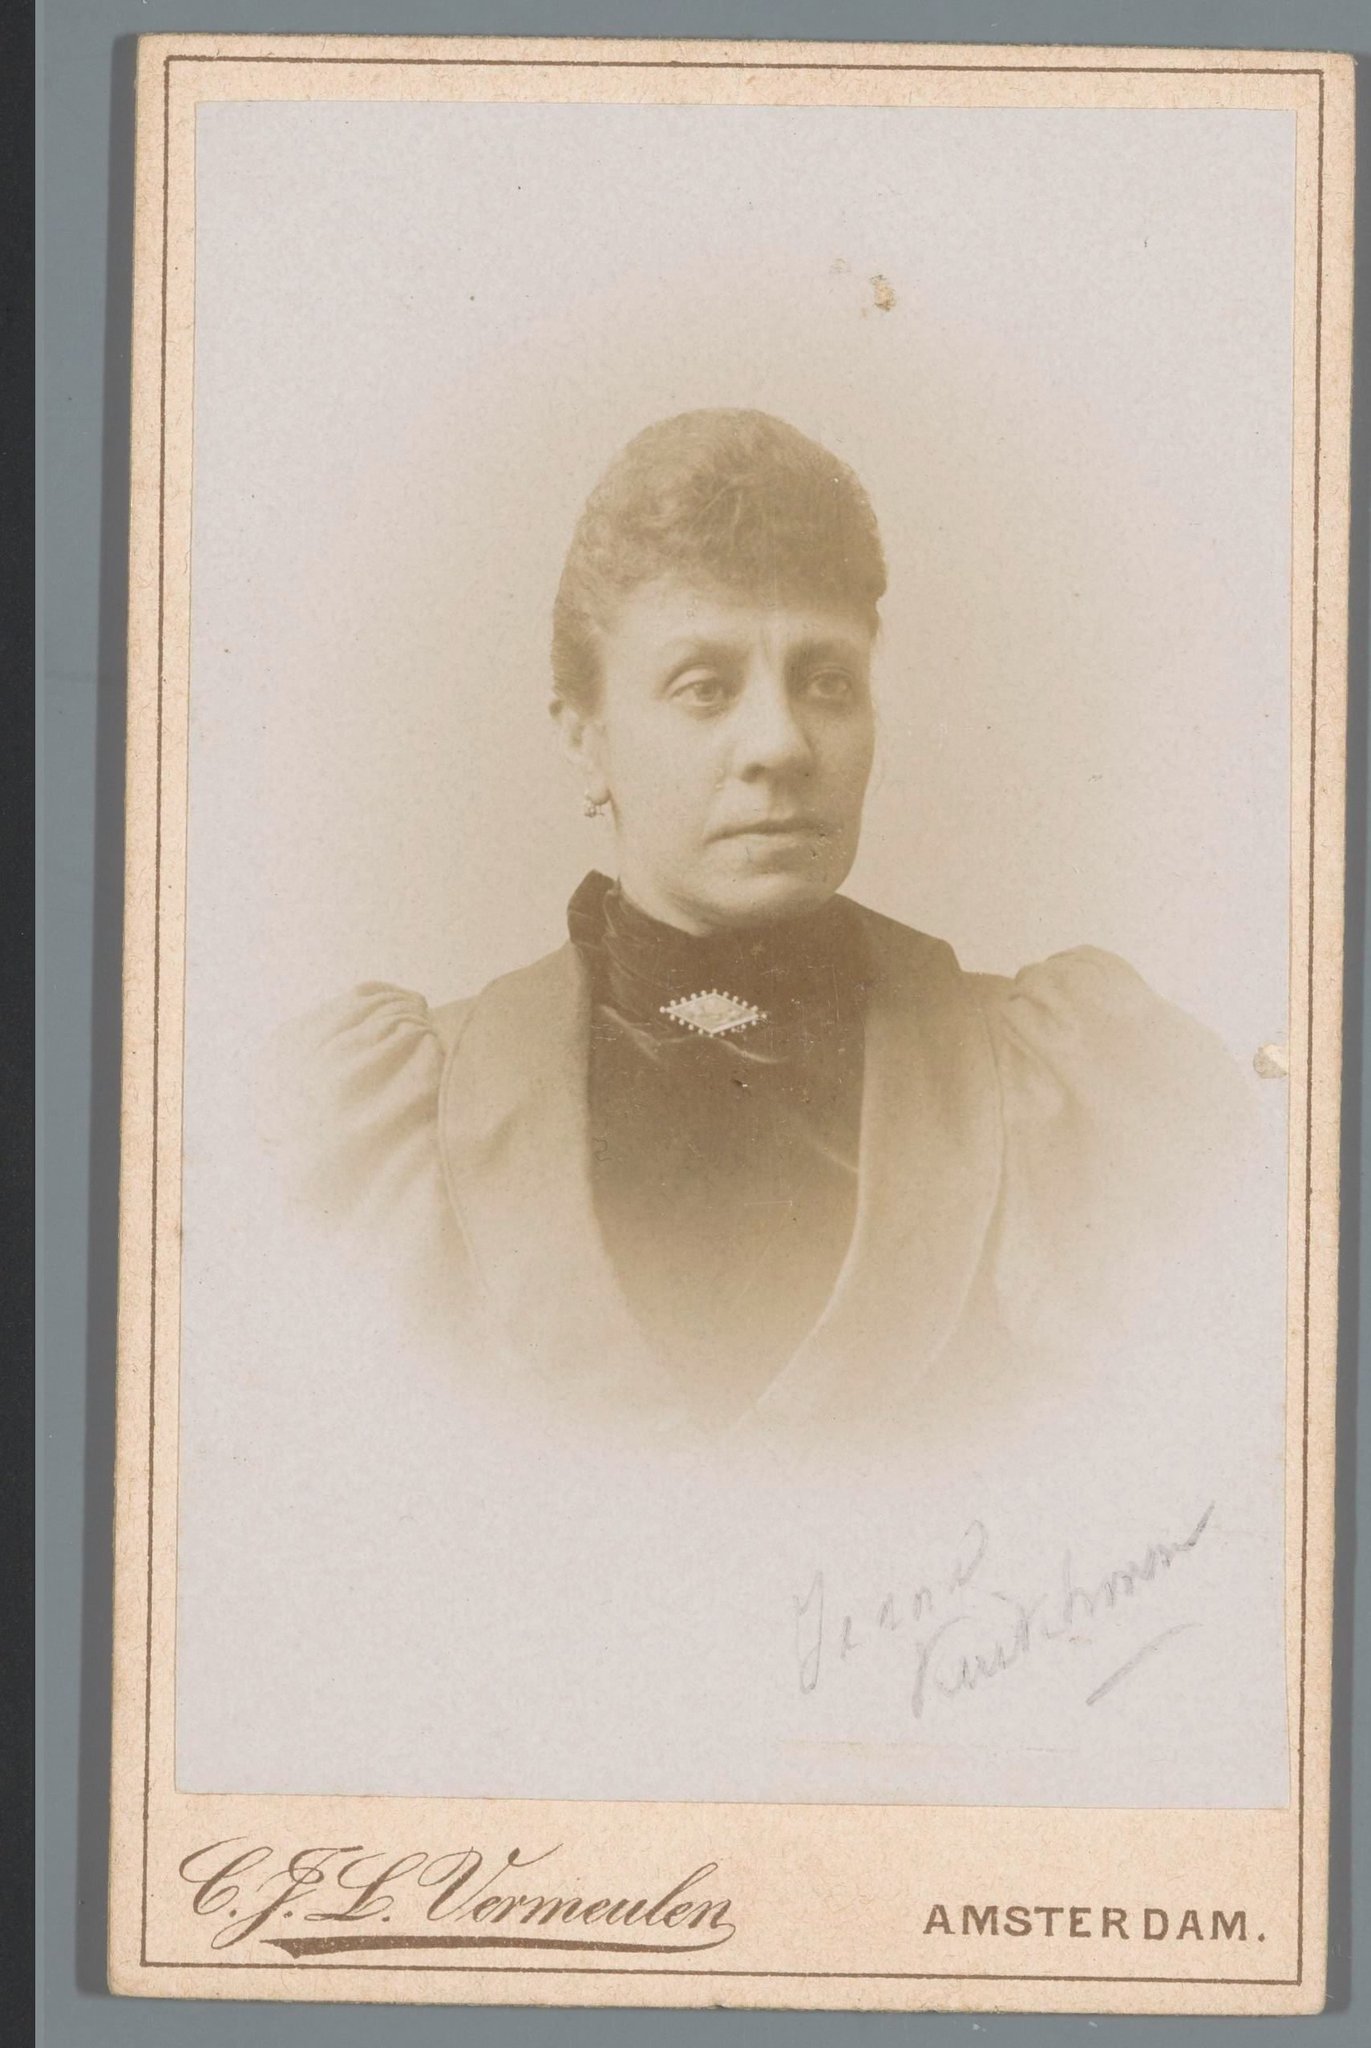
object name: photograph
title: Portret van een onbekende vrouw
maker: cornelis johannes lodewicus vermeulen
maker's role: fotograaf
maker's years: 1861-1936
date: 1888-1896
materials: cardboard, photographic support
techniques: collodion silver print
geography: amsterdam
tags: historical persons - bb - woman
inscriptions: inscription: ‘Photographische/ ATELIERS/ C. J. L. Vermeulen/ Heerenstraat 6,/ Heiligenweg/ hoek Singel/ AMSTERDAM,/ Specialiteit in vergrootingen.’, inscription: ‘Jenny Kuitman’